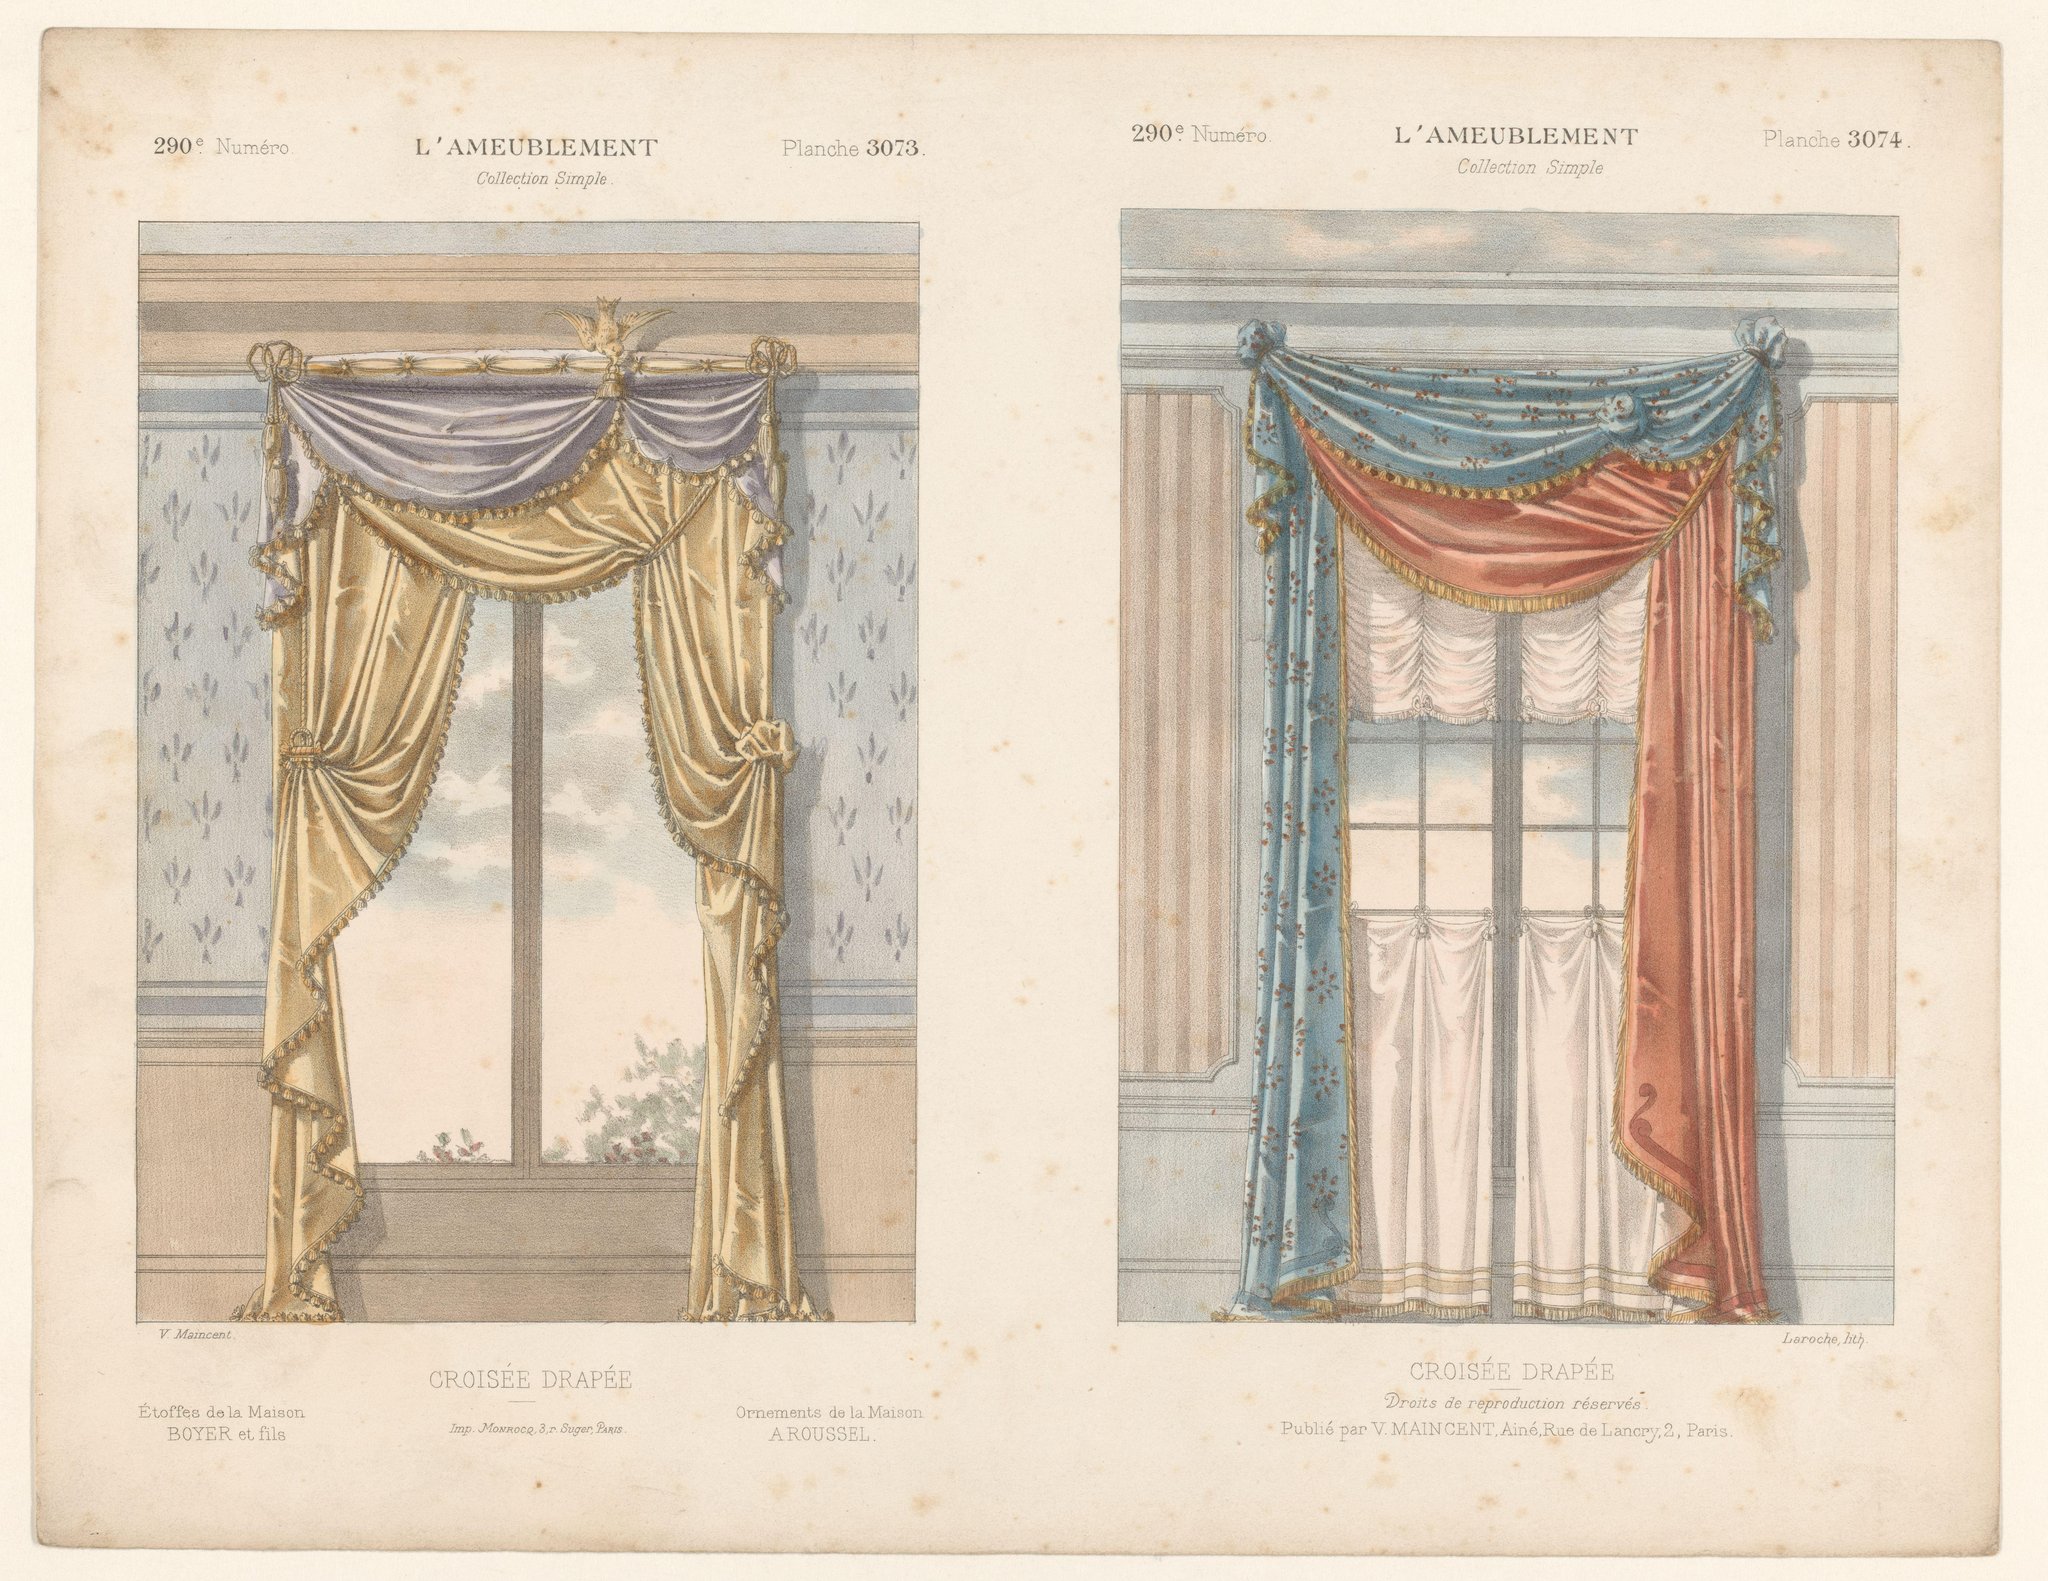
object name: print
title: Twee vensters met gordijnen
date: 1895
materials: paper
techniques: hand coloring, lithograph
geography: paris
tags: window, hangings and drapery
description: Twee vensters met gedrapeerde gordijnen. Prent uit 290e Livraison.